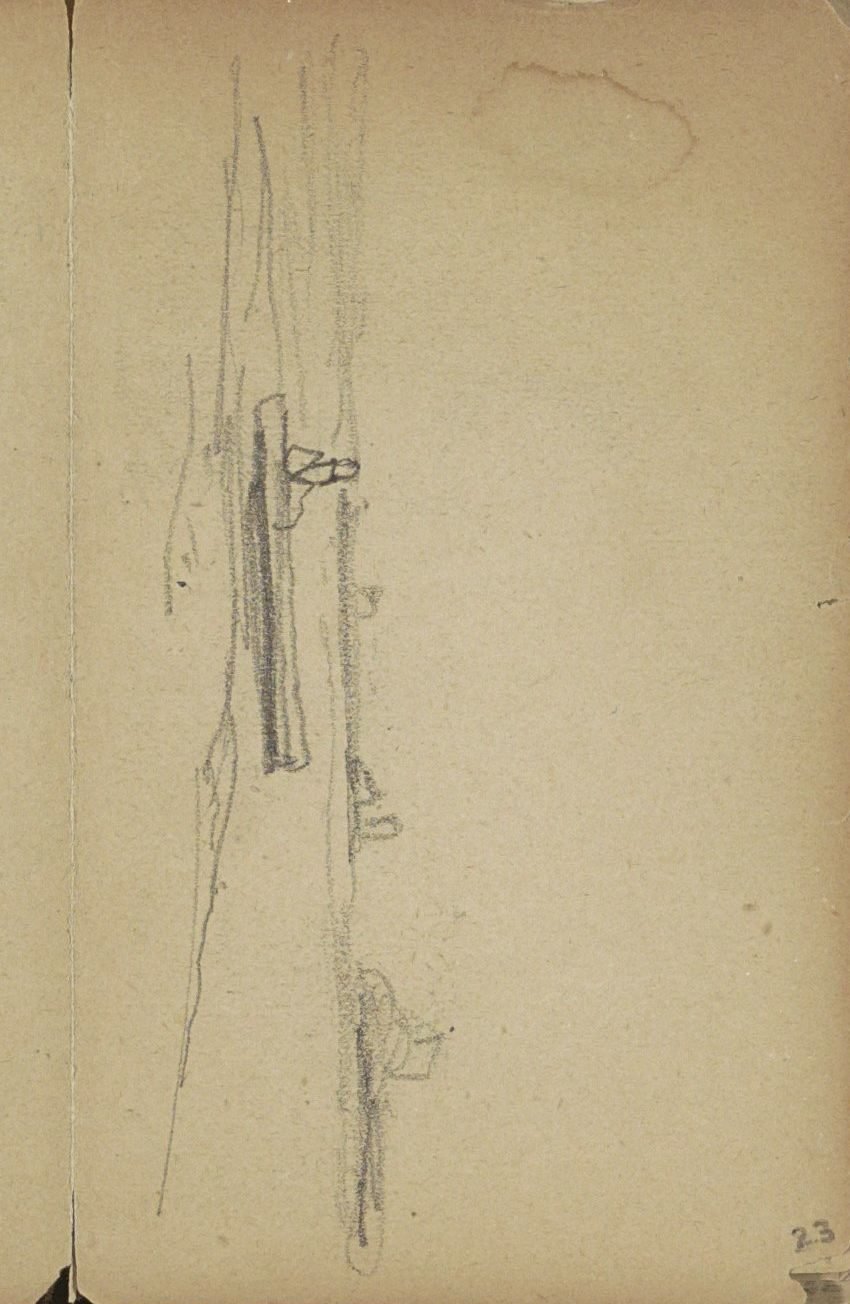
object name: sketchbook leaf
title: Figuur in een roeiboot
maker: johan hendrik weissenbruch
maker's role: draughtsman, painter, print maker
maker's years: 1824-1903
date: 1834-1903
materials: paper, pencil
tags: rowing-boat, canoe, etc.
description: Blad 23 recto uit een schetsboek met 32 bladen.